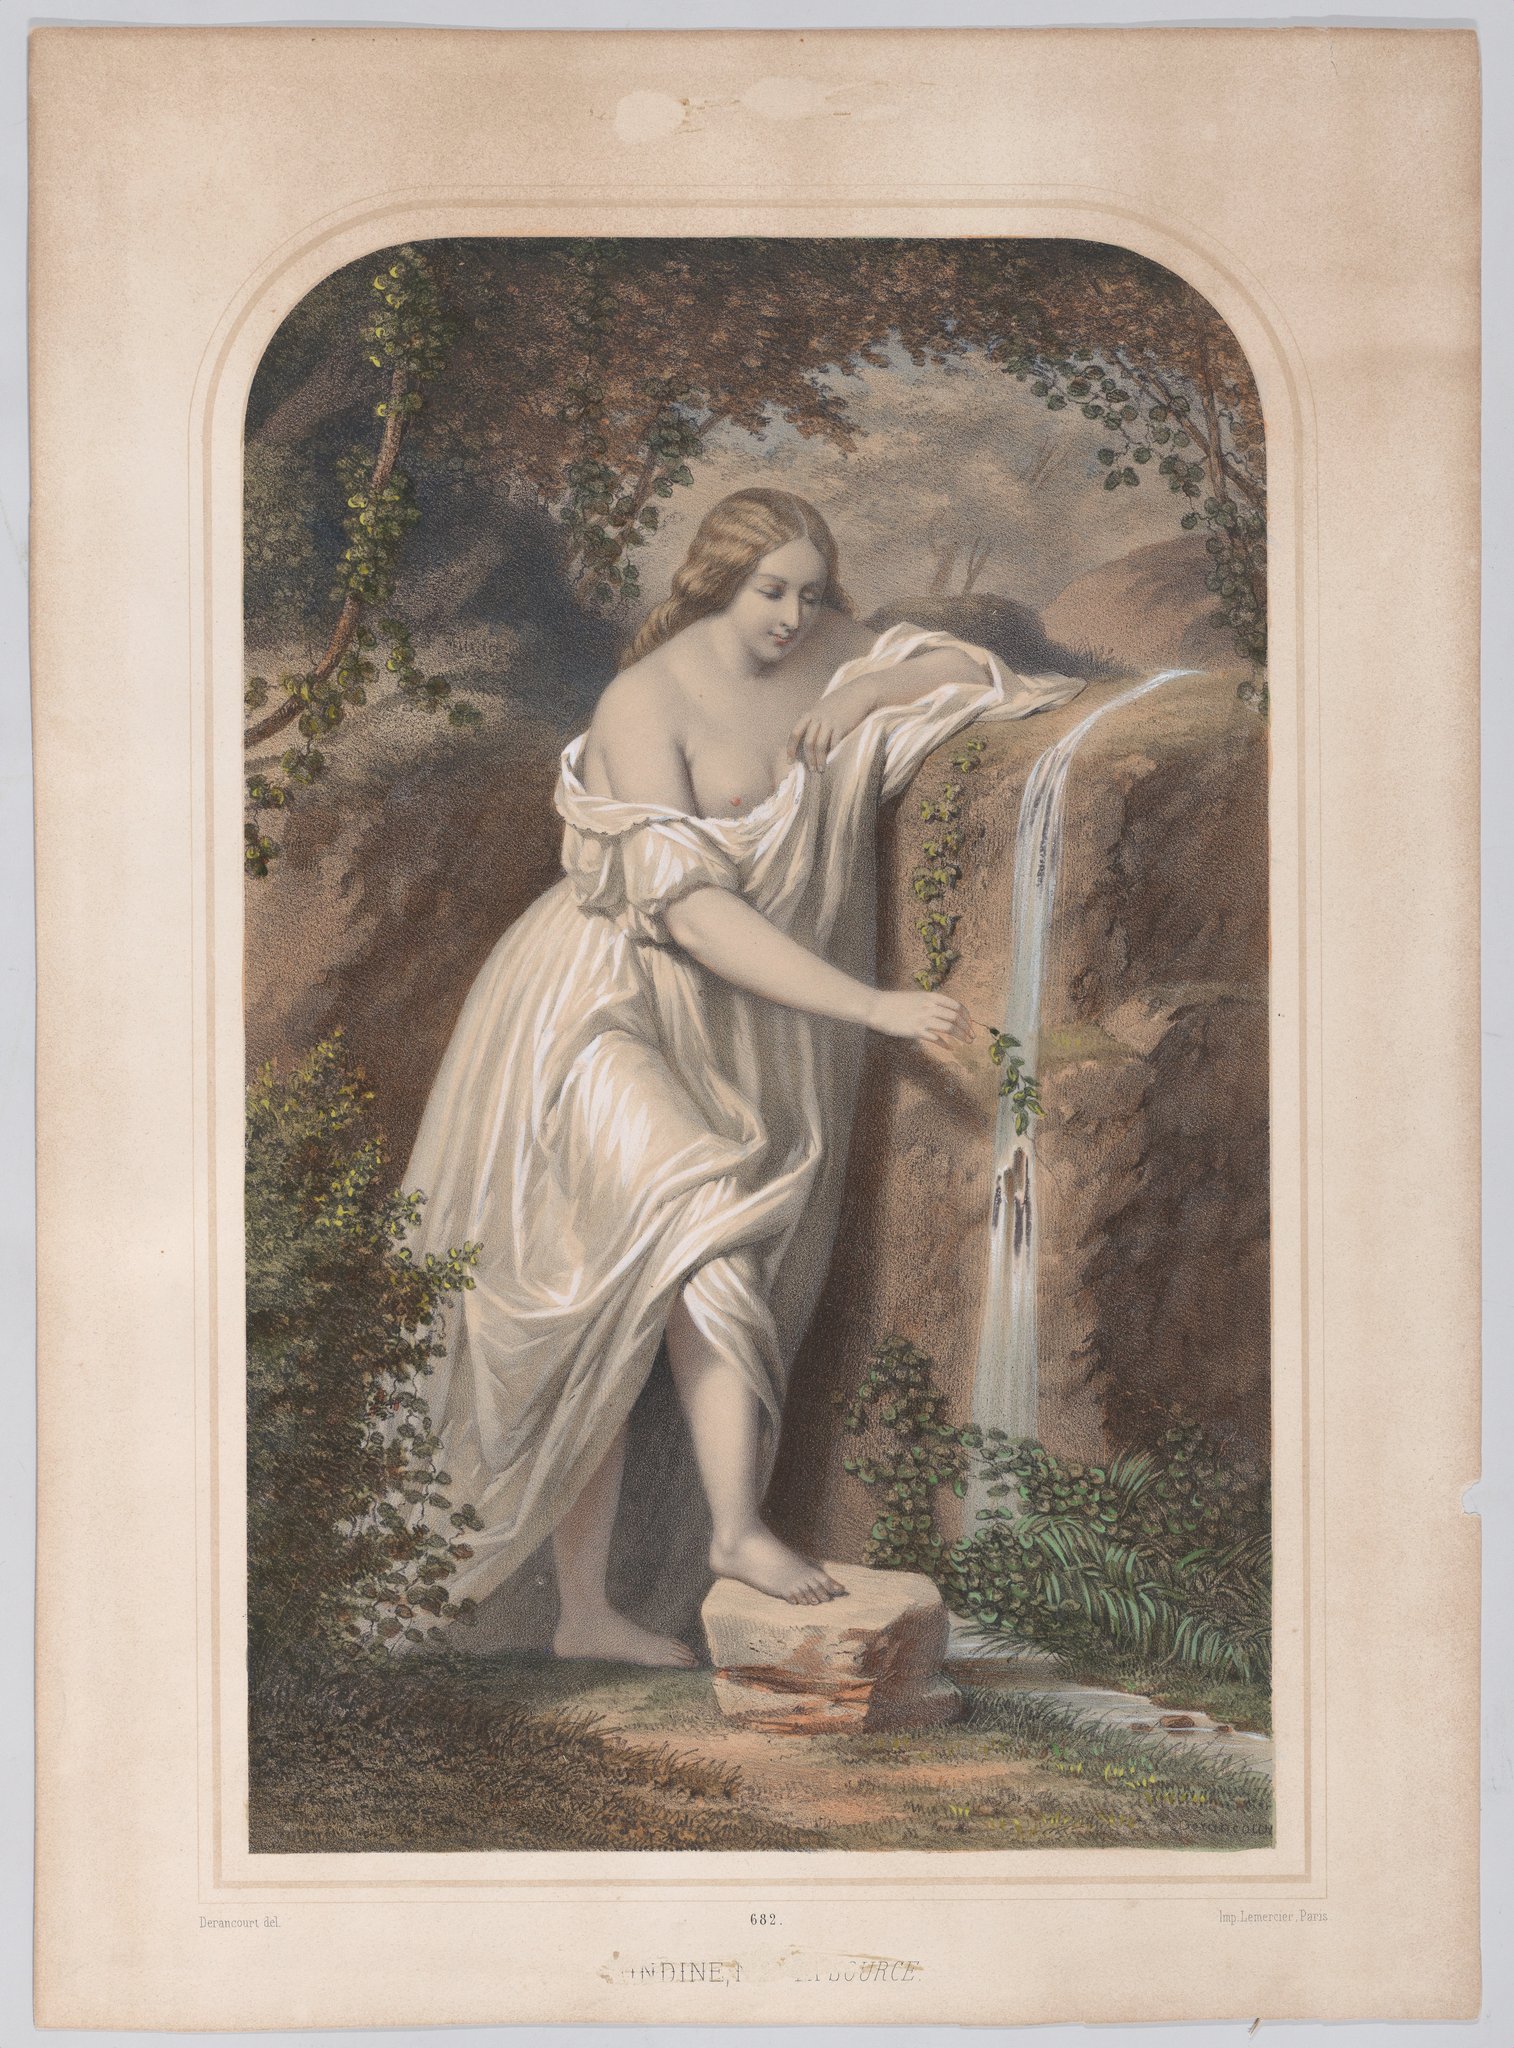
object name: print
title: La Source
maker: c. derancourt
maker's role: artist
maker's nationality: french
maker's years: 1800-1900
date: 1842-1871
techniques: lithograph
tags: women